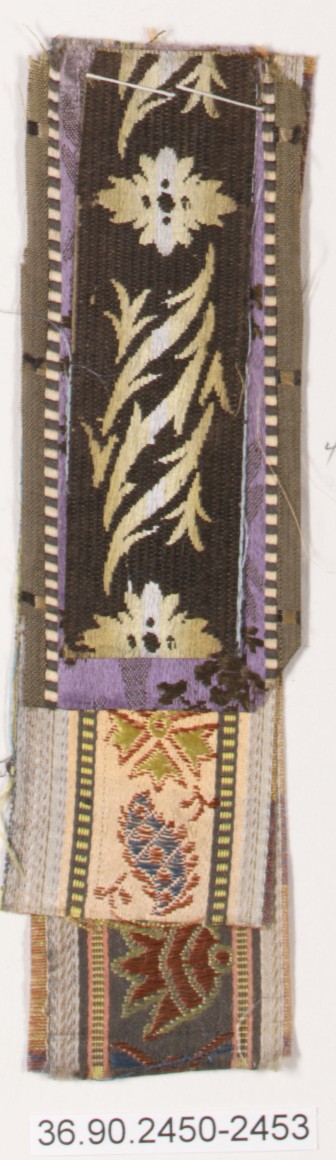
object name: ribbon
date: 1801-1900